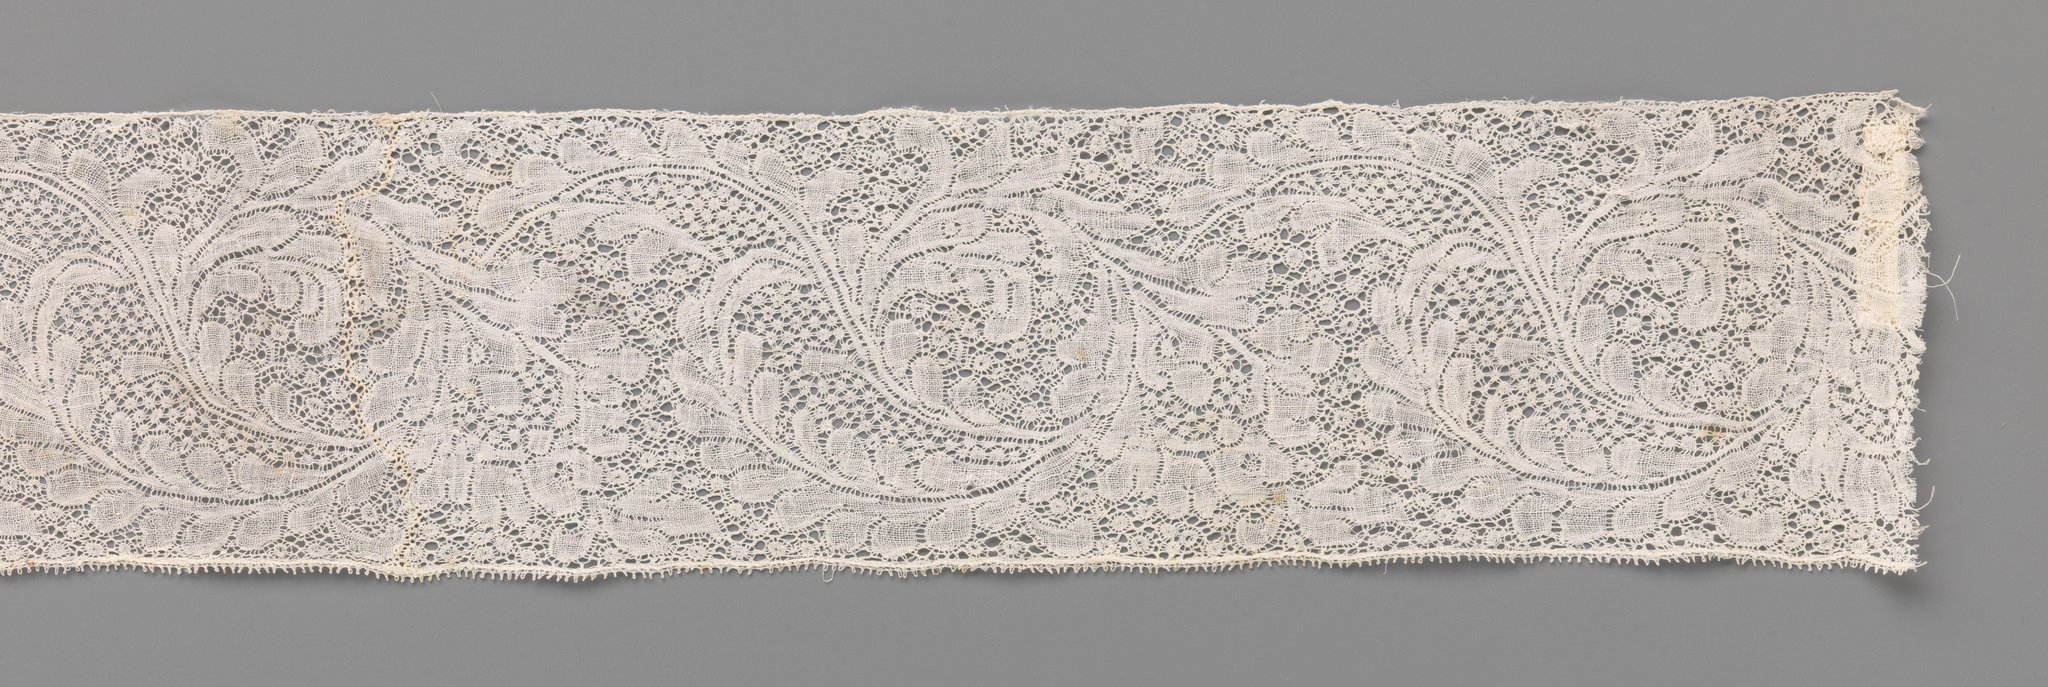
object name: strip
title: Strook kloskant met s-vormig cartouche en peervormige bloem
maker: Anonymous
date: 1725-1749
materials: linen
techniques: lace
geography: southern netherlands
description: Strook naturelkleurige kloskant, Binche-kant. Het zich herhalende en doorlopende patroon bestaat uit een s-vormige cartouche, gevormd door twee lange gevederde bladeren. Halverwege bovenin splitst een gevederd blad zich af en loopt met een grote boog, in tegengestelde richting, zodat er een cirkelvorm ontstaat en de grote peervormige bloem aan het uiteinde de onderzijde van de strook raakt. De motieven lopen in elkaar over en zijn, waar ze elkaar niet raken, met elkaar verbonden door siergronden, verschillende sneeuwvlokkengronden. De motieven zijn gemaakt in linnenslag met opengewerkte randjes. Netslagvullingen zijn versierd met sneeuwvlokken. Boven- en onderzijde van de strook zijn recht afgewerkt, waarbij de onderzijde is voorzien van picots. Er lopen drie naden over de breedte van de strook.